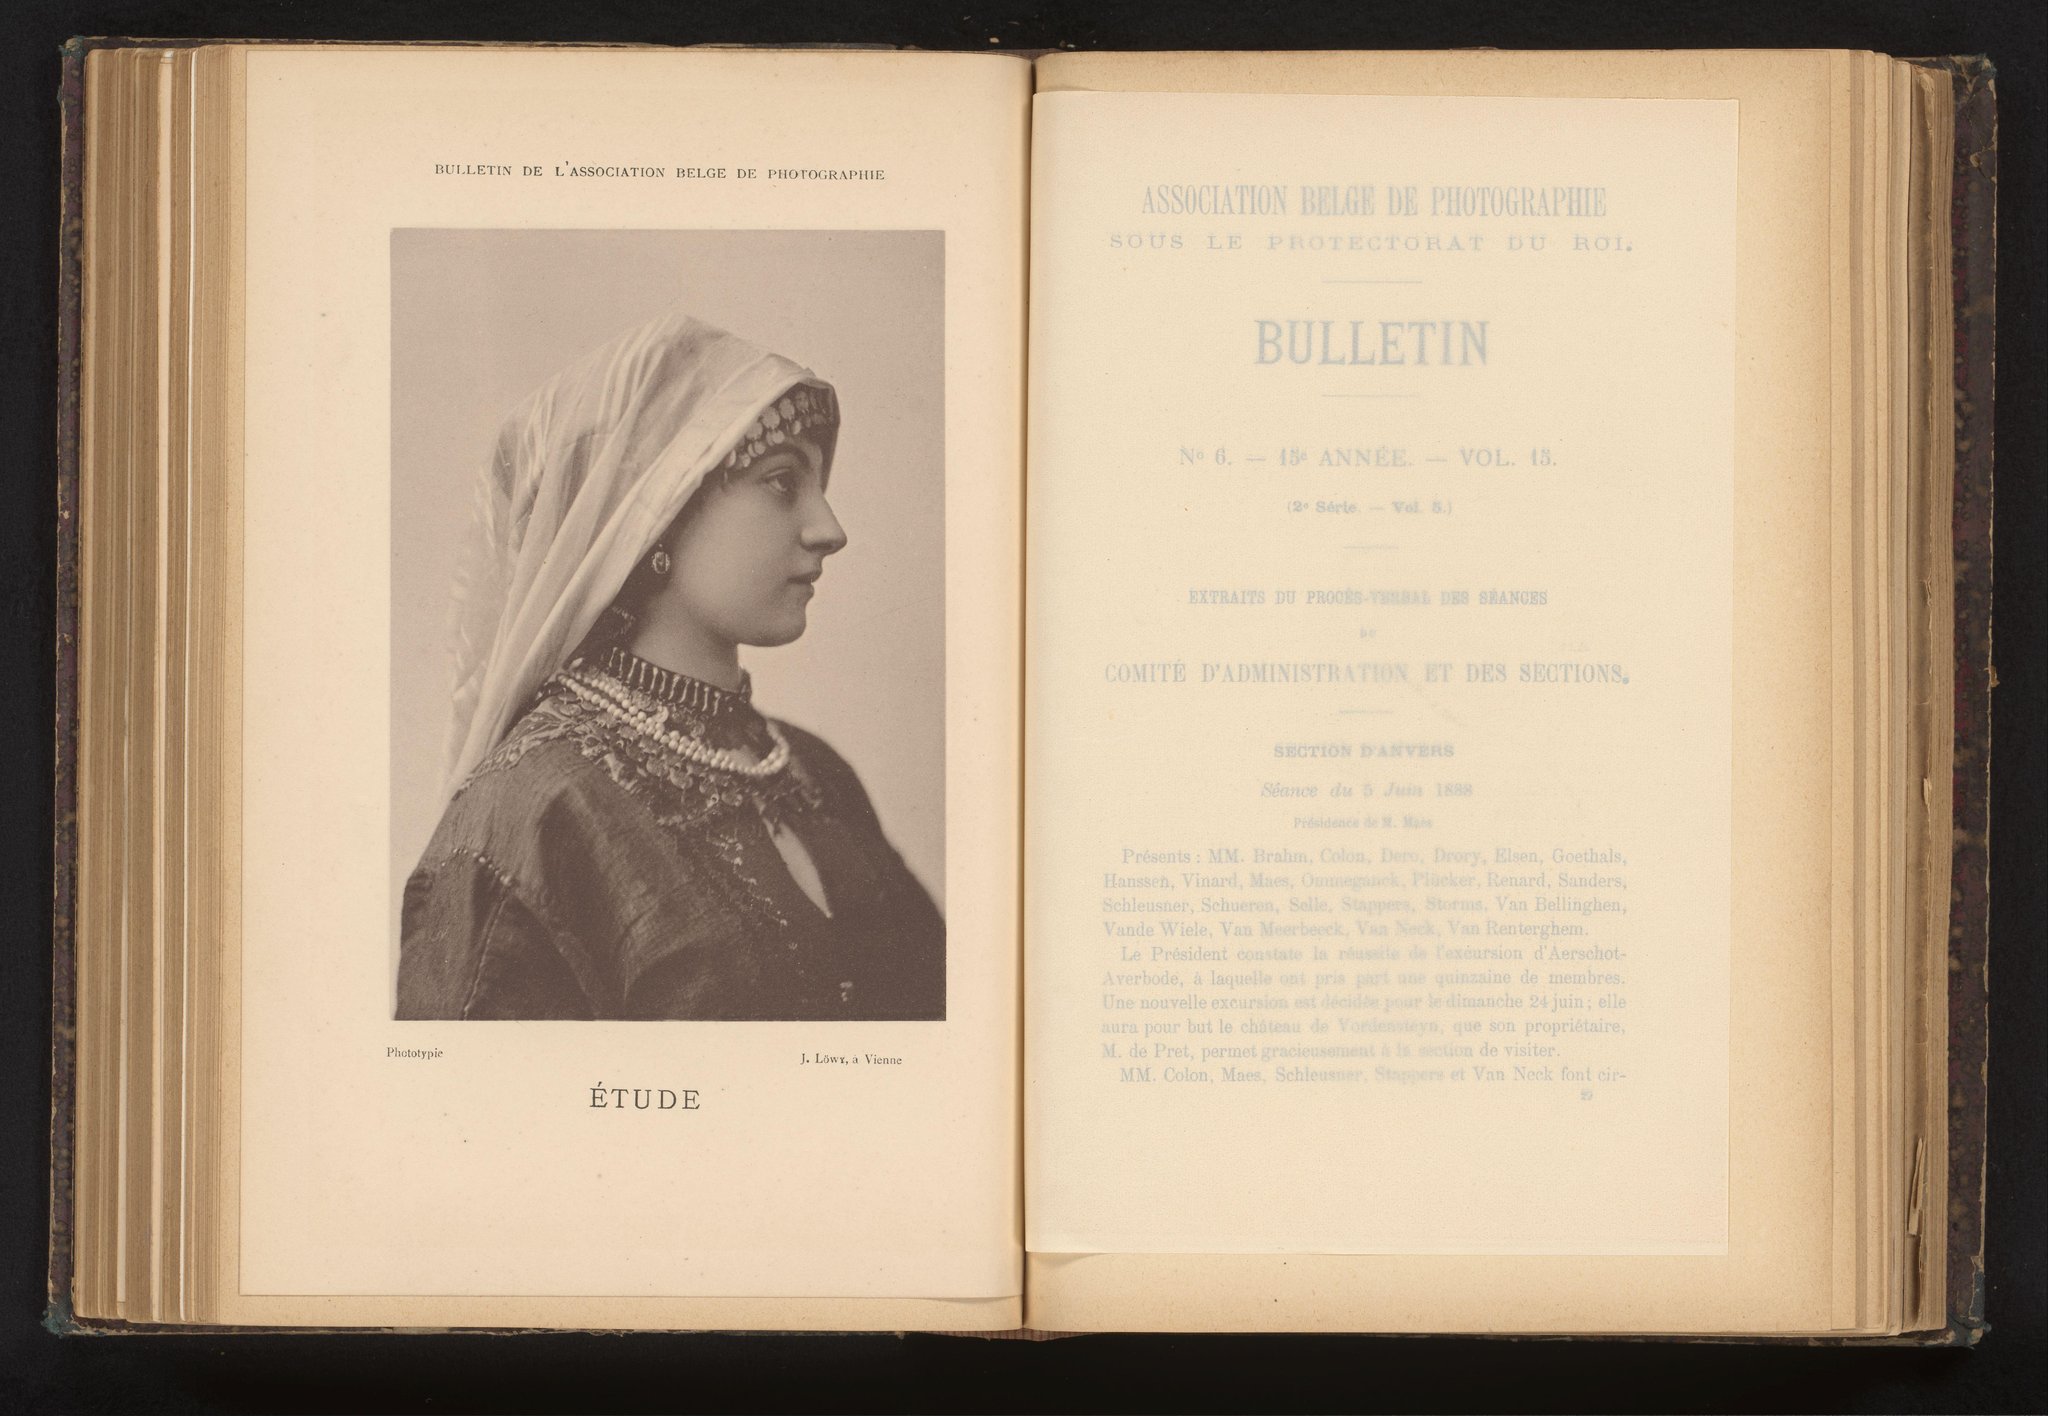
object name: page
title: Portret van een onbekende jonge vrouw met een hoofddoek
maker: josef löwy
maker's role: publisher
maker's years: 1835-1902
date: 1883-1888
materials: paper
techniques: photograph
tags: adolescent, young woman, maiden, head-gear (with name), historical persons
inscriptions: inscription: ‘Bulletin de l'association belge de photographie’